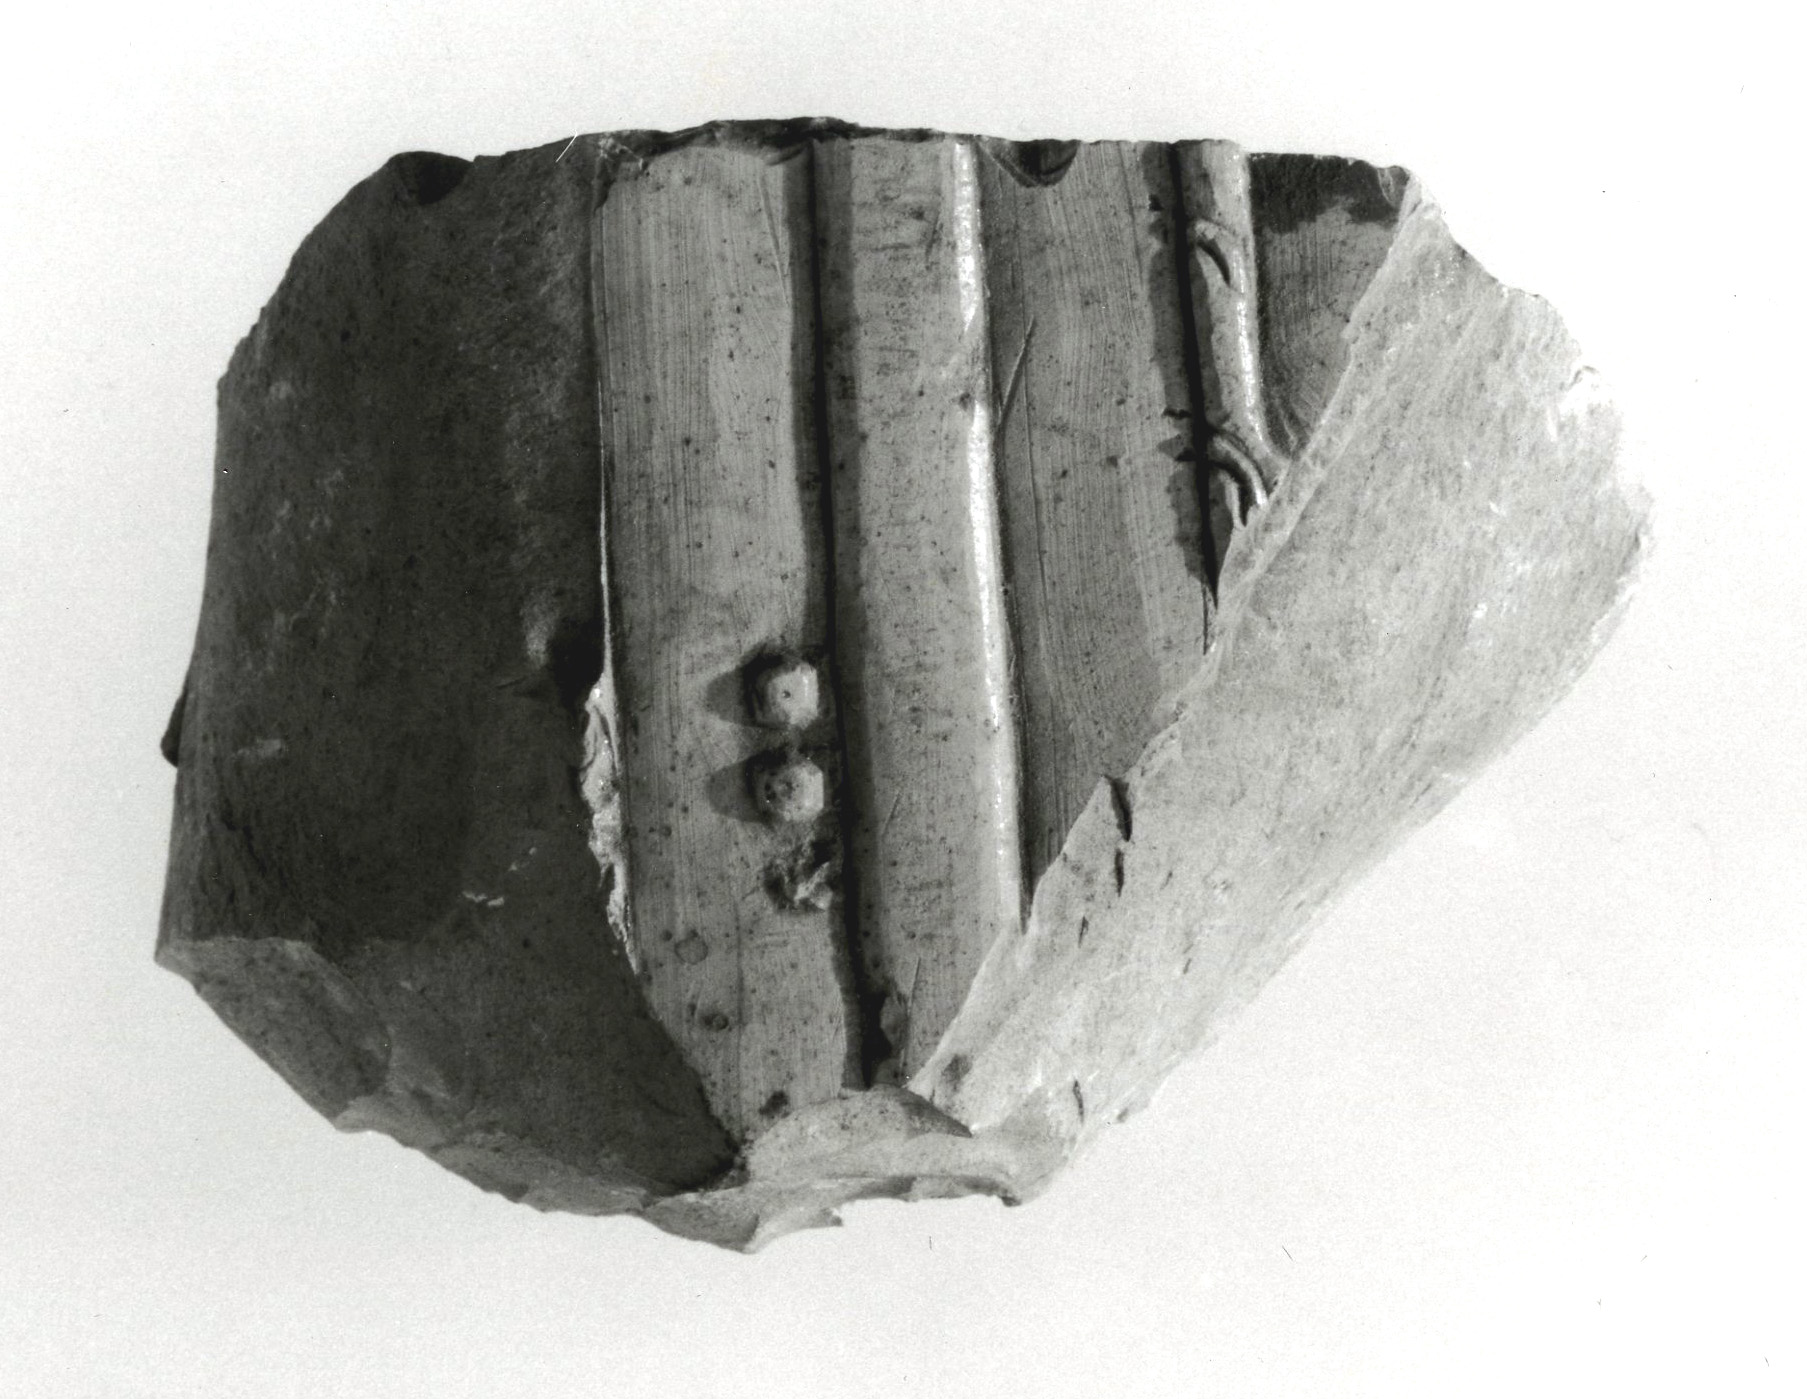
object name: relief, tomb of nespekashuty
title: Raised relief fragment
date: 664-610 BCE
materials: limestone, varnish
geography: egypt